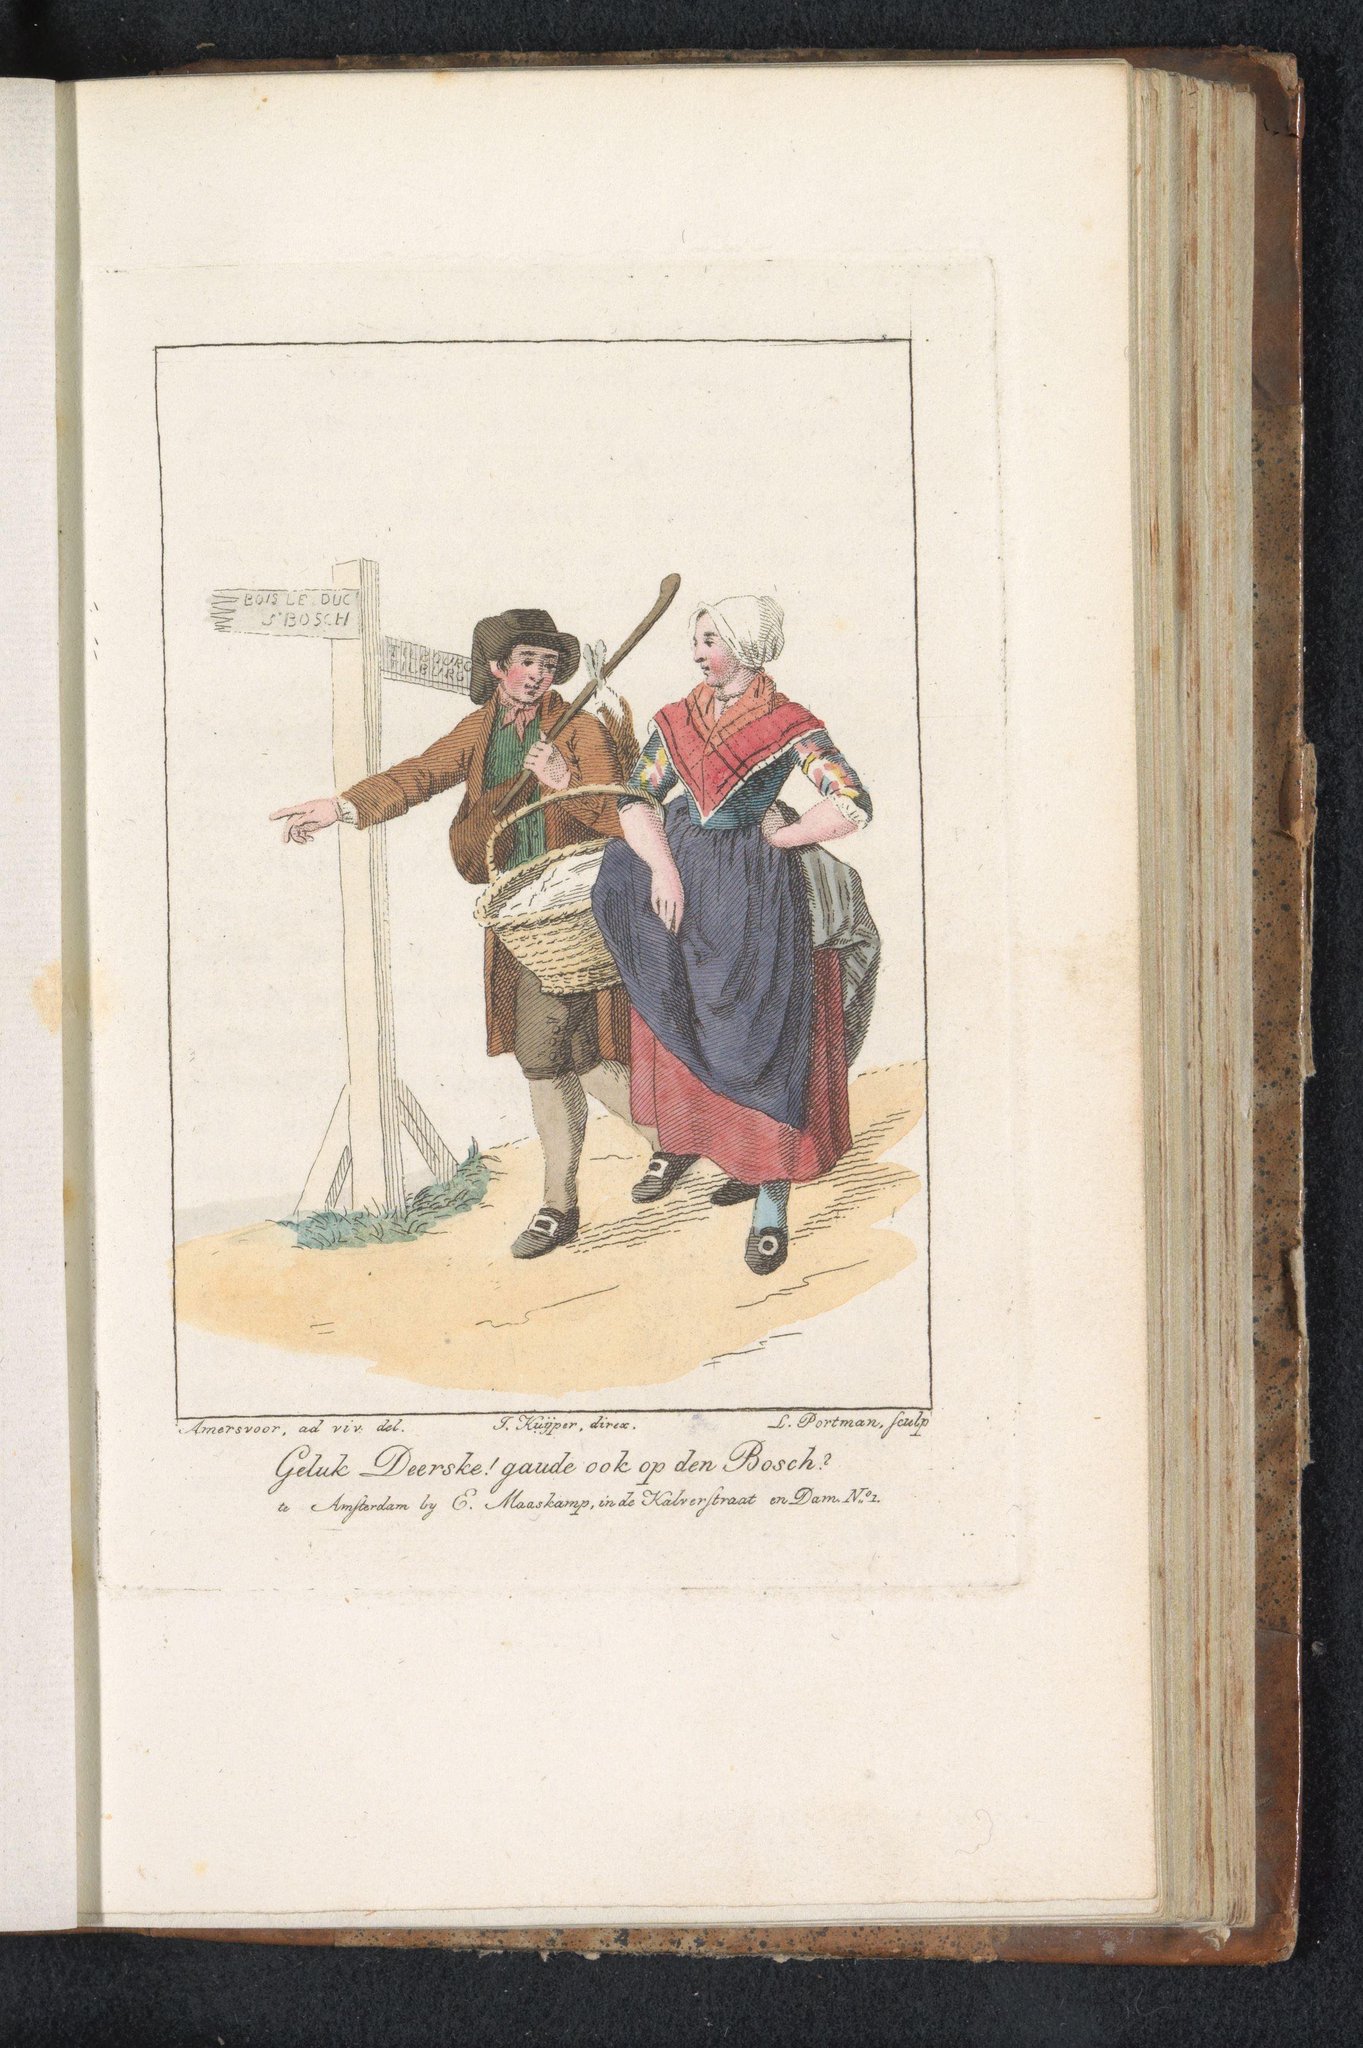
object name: print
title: Boer en boerin uit Noord-Brabant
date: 1807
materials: paper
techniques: etching, hand coloring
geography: north brabant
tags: folk costume, regional costume, clothes, costume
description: Een boer en boerin uit het dorp Cromhout onderweg naar Den Bosch. Het meisje draagt een grote mand aan haar arm, de jongen een stok met haas en knapzak. Onderdeel van de verkleinde kopieën uit 1807 naar de platen van Nederlandse klederdrachten uit de jaren 1803-1807.